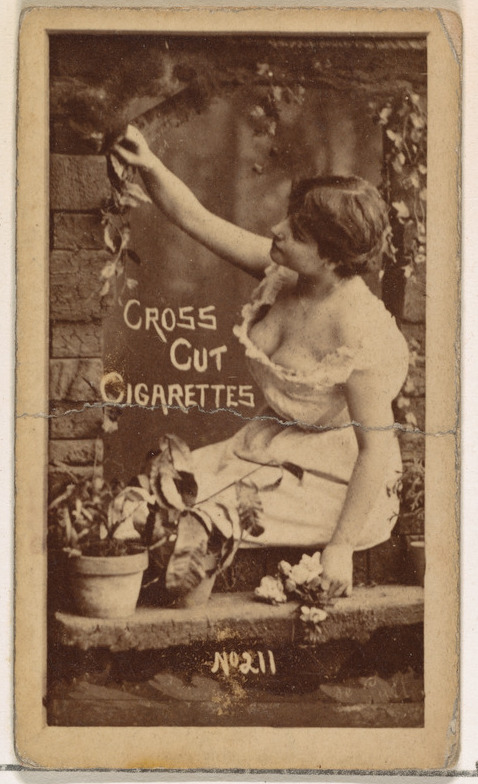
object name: print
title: Card Number 211, from the Actors and Actresses series (N145-1) issued by Duke Sons & Co. to promote Cross Cut Cigarettes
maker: w. duke, sons & co.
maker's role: publisher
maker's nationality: american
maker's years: 1870-1920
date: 1880-1889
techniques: albumen silver print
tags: women,actresses